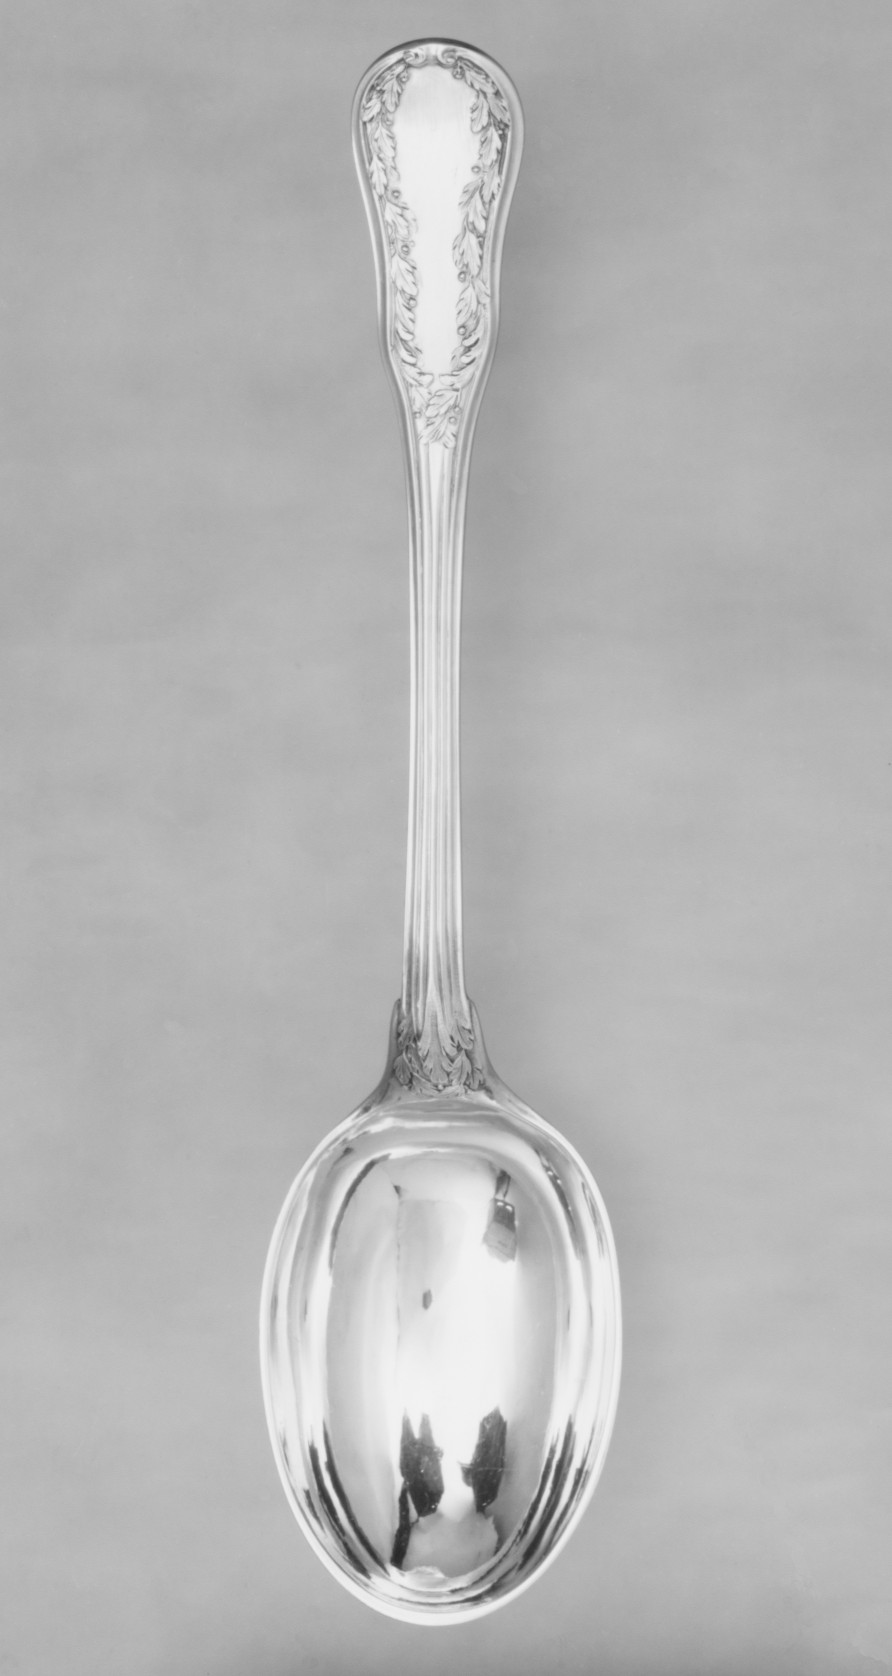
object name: spoon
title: Serving spoon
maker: jean-etienne langlois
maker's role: maker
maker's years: 1740-1823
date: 1784-1785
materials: silver gilt